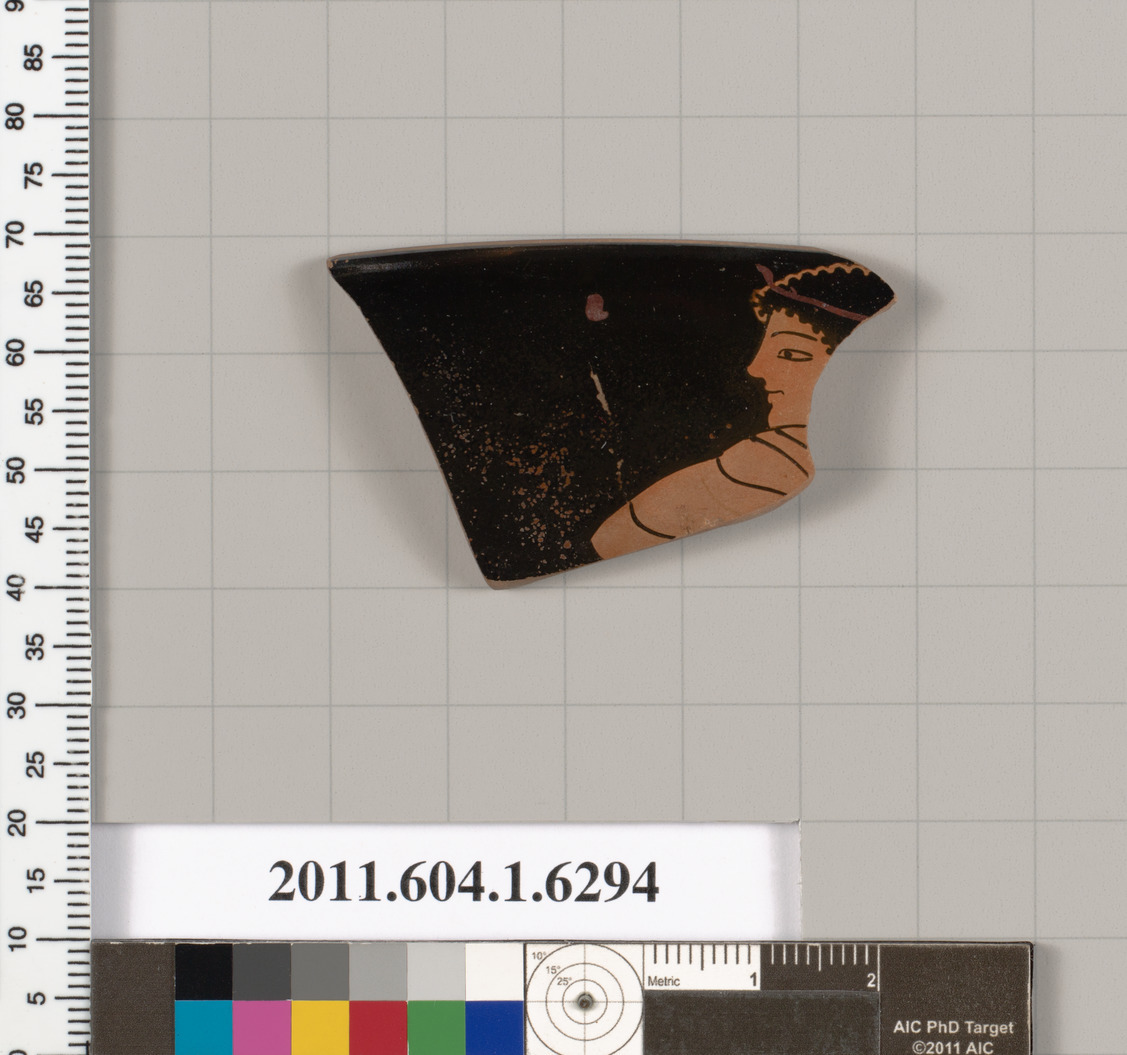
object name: kylix fragment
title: Terracotta rim fragment of a kylix (drinking cup)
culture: greek, attic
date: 500-480 BCE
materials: terracotta